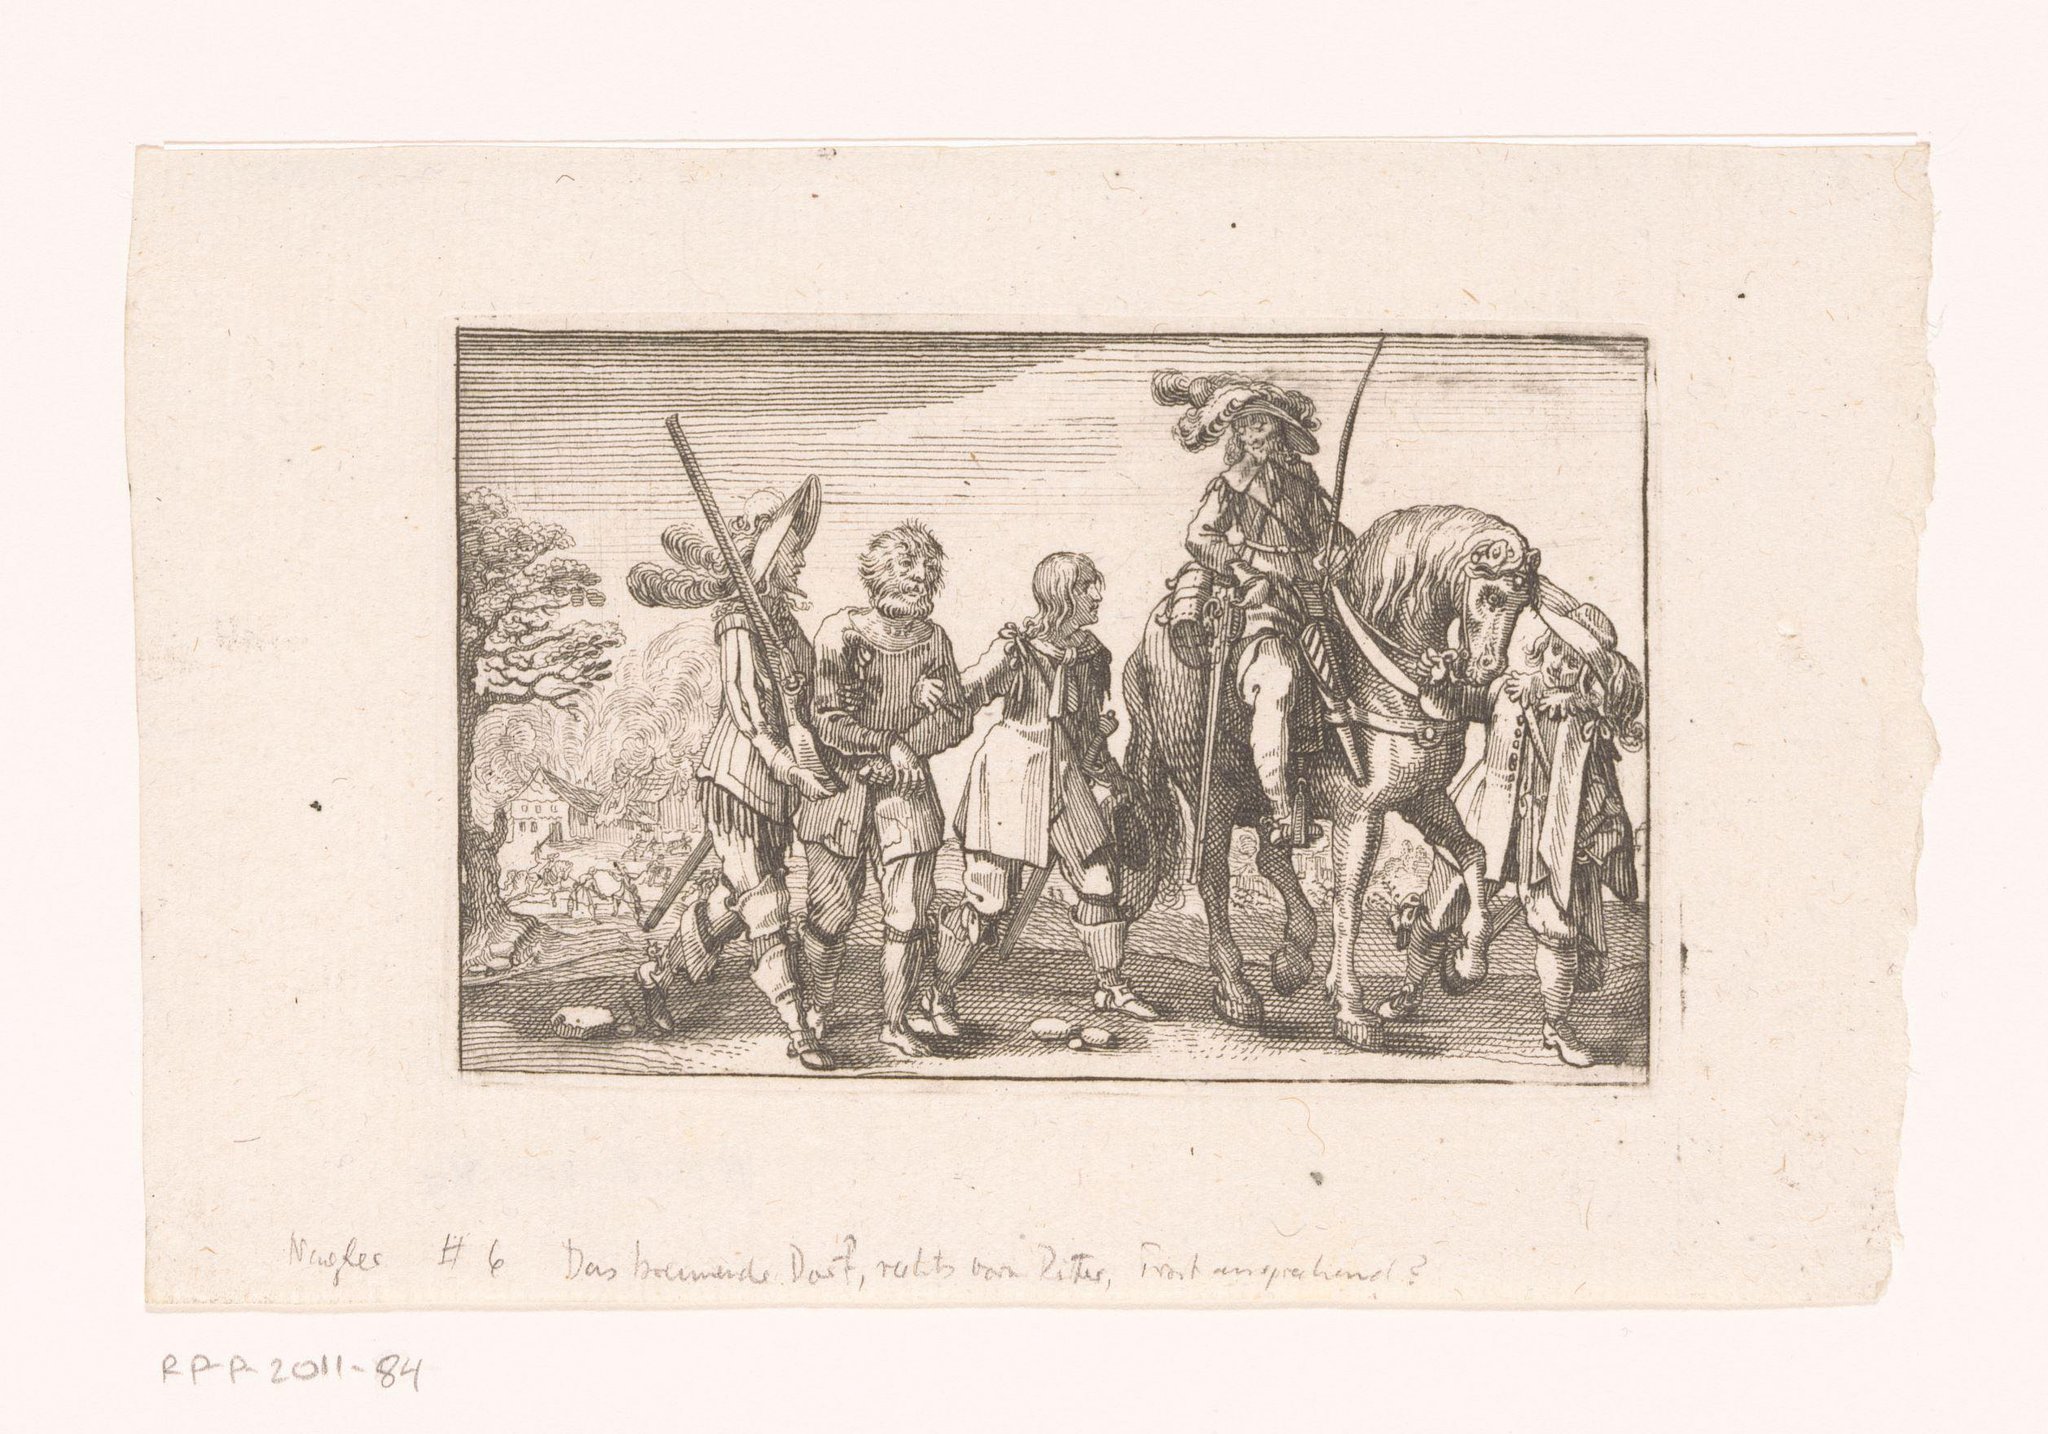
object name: print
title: Boer en soldaten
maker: rudolph meyer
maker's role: print maker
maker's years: 1605-1638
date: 1615-1638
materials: paper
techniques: etching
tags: riding a horse, ass, or mule; rider, horseman, farmers, fight between farmers and soldiers, village, the soldier; the soldier's life, burning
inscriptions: collector's mark: Lugt 2228, collector's mark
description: Onderdeel van een serie van vier prenten over de Dertigjarige Oorlog (1618-1648). Zie: Hollstein German XXVIII 31-34.